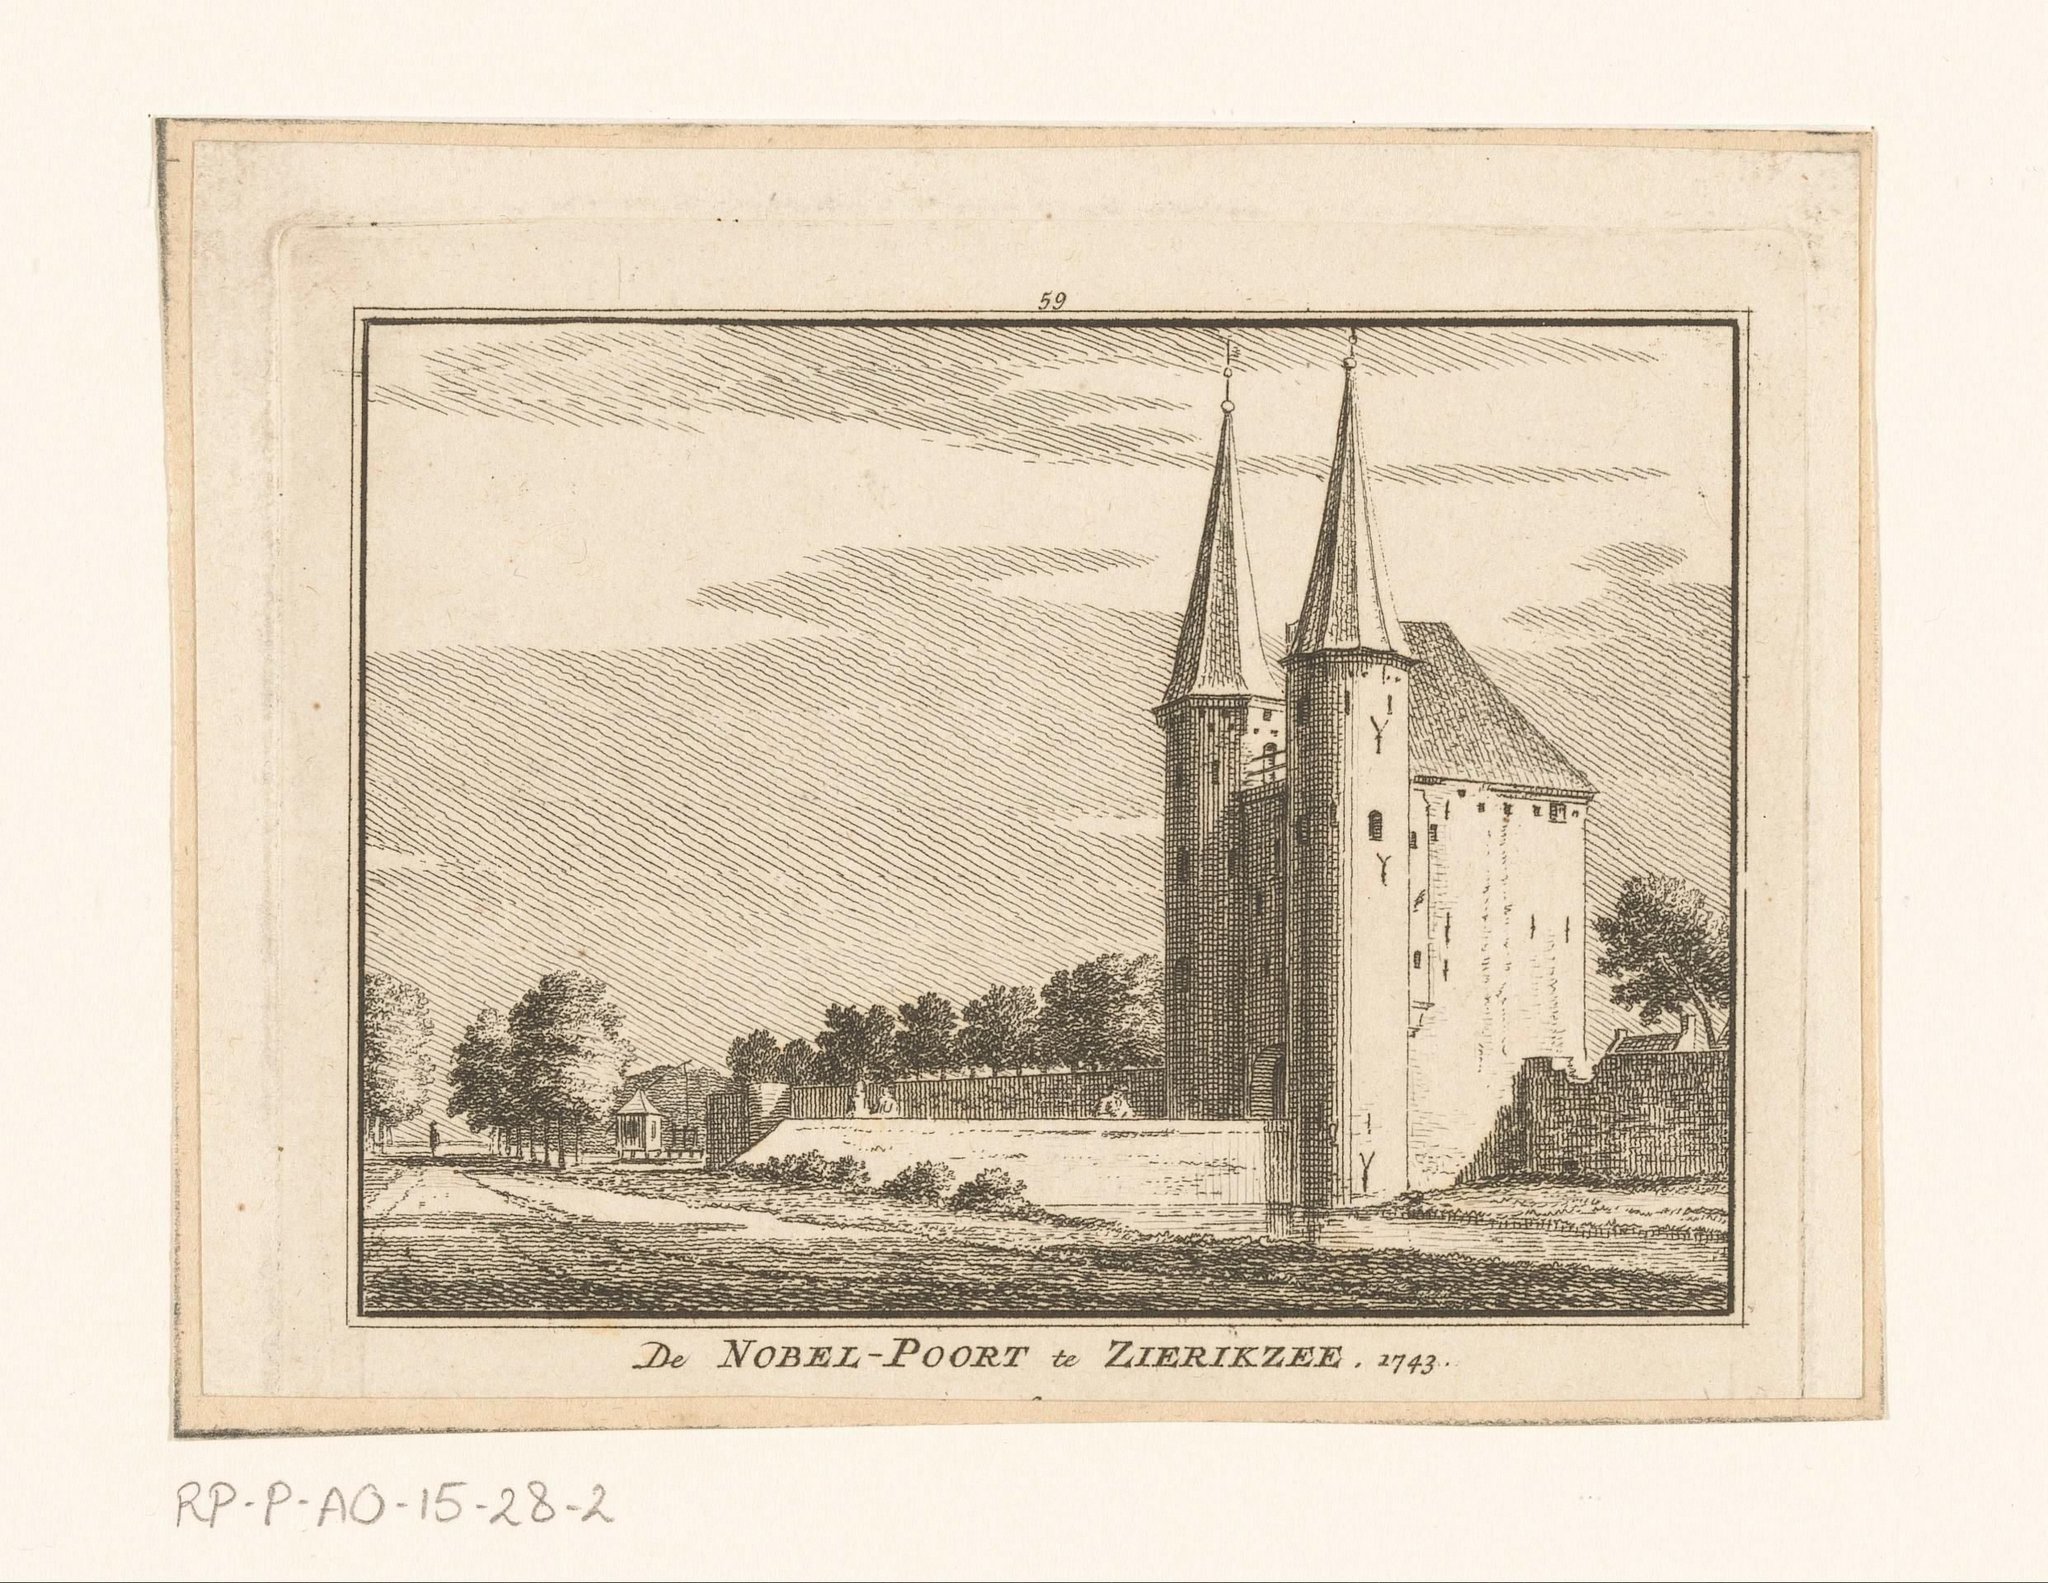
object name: print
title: De Nobel-Poort te Zierikzee, 1743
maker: hendrik spilman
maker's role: draughtsman, painter, print maker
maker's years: 1721-1784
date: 1754-1792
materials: paper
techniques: etching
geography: haarlem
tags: city-gate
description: Prent ook gebruikt in: Het verheerlykt Nederland of kabinet van hedendaagsche gezigten van steden, dorpen (…). 9 delen. Amsterdam: Isaak Tirion en weduwe Isaak Tirion, 1745-1774, dl. 5 (1754), ill. 59. Of in: Nederlandsche tafereelen; of eene keurige verzameling van negen honderd fraaije gezigten van steden, dorpen, sloten, oudheden [….]. 9 delen. Amsterdam: Jan de Groot, 1792, dl. 5, ill. 59.